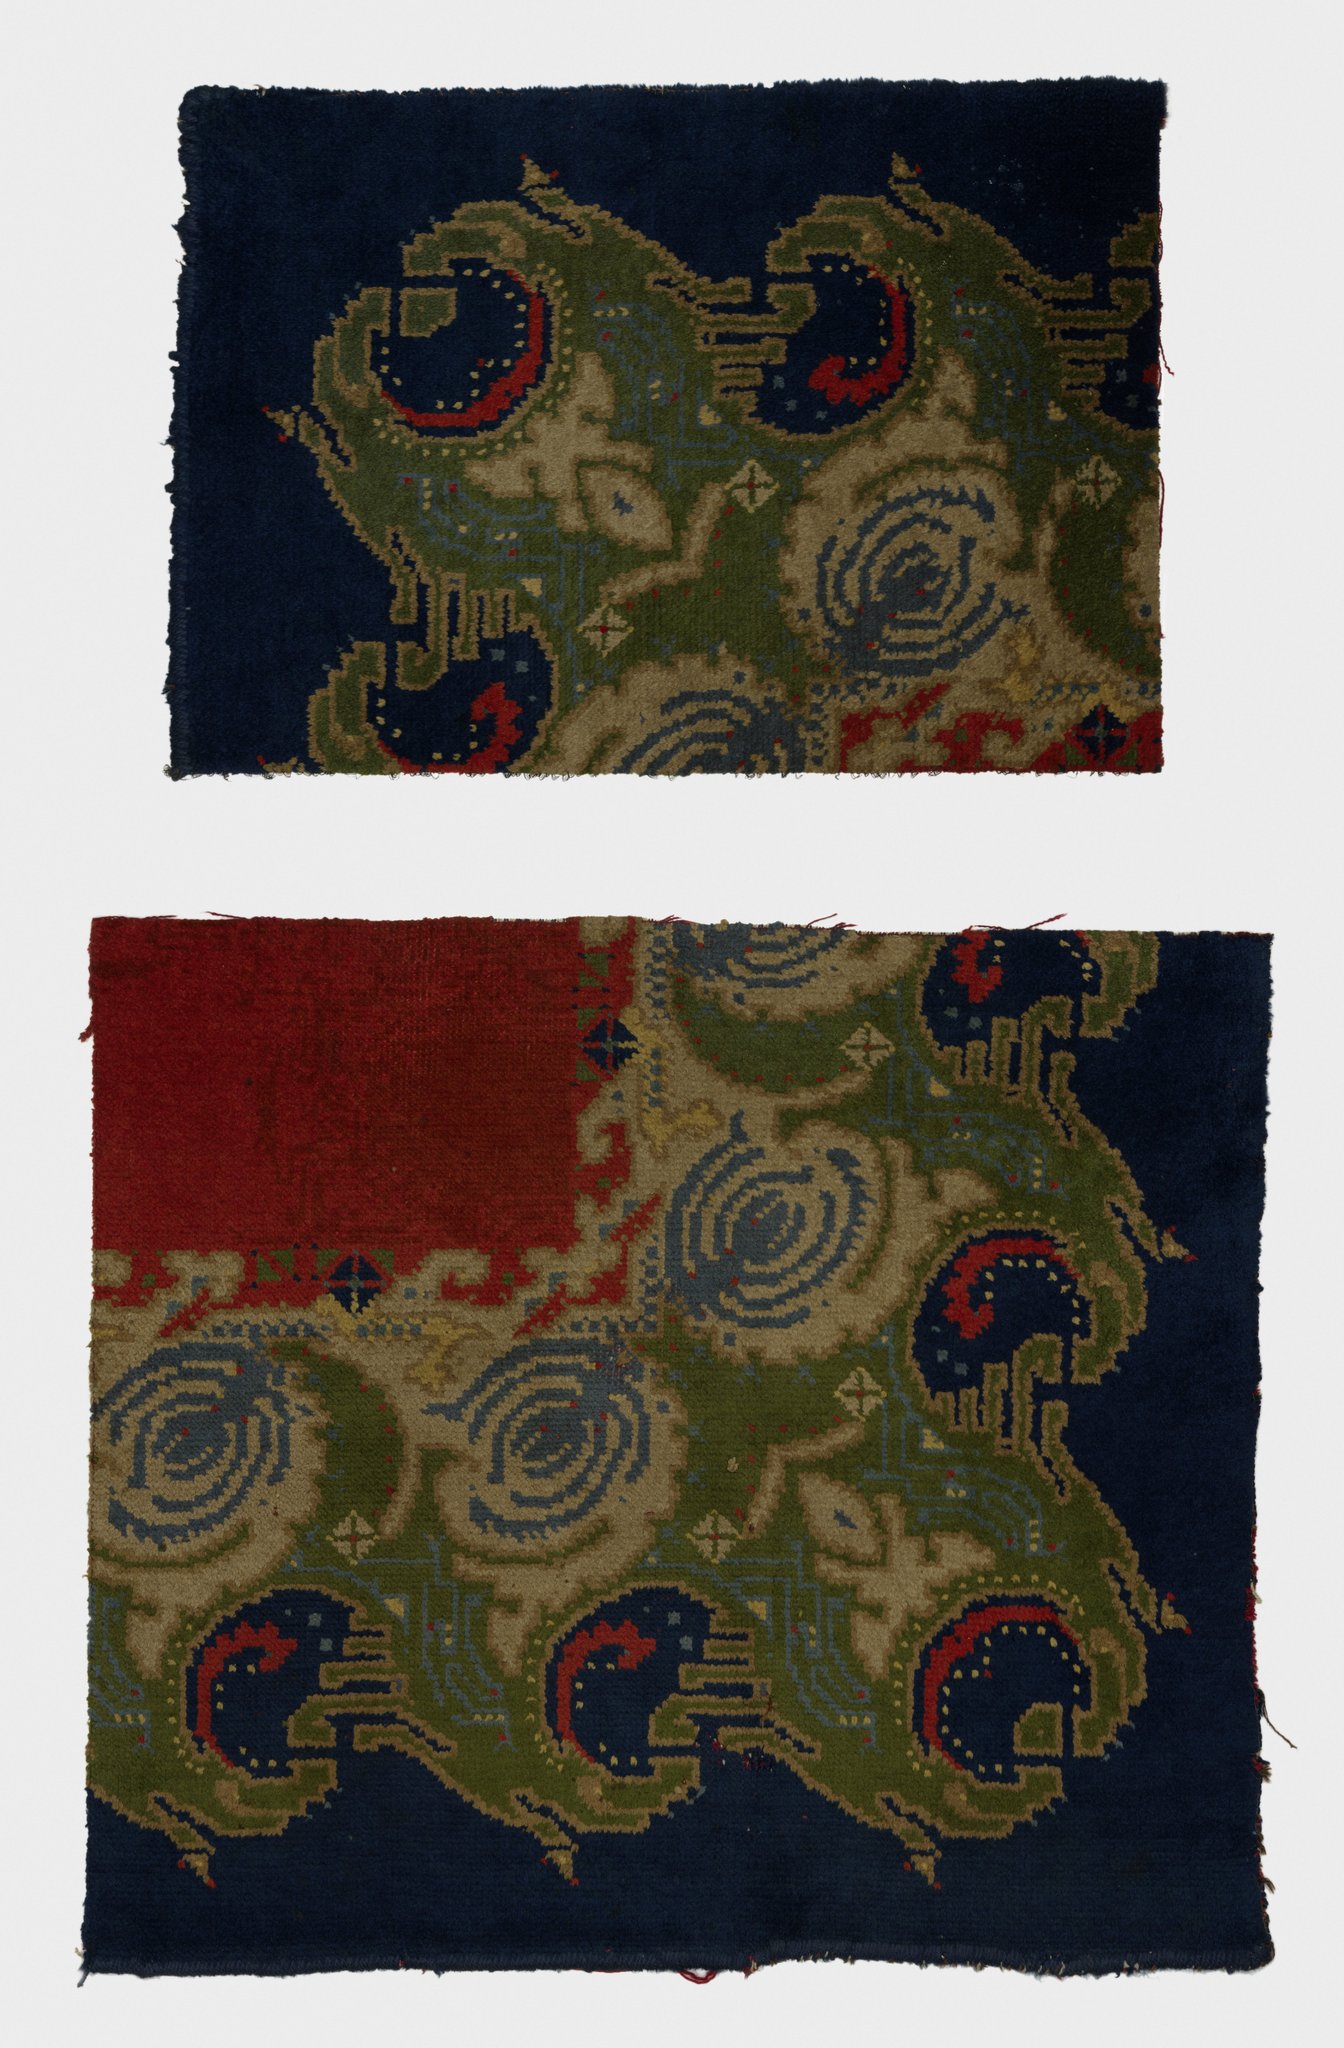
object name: deventer tapijt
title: Fragment van een Deventer tapijt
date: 1910-1925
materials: wool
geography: deventer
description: Fragment van een handgeknoopt Deventer tapijt met rood middenveld en abstracte randdecoratie in groen, beige, rood en blauw. Donkerblauwe rand. Het tapijt is vervaardigd voor de villa van de familie Pull ter Gunne aan de Prinses Marielaan te Apeldoorn.